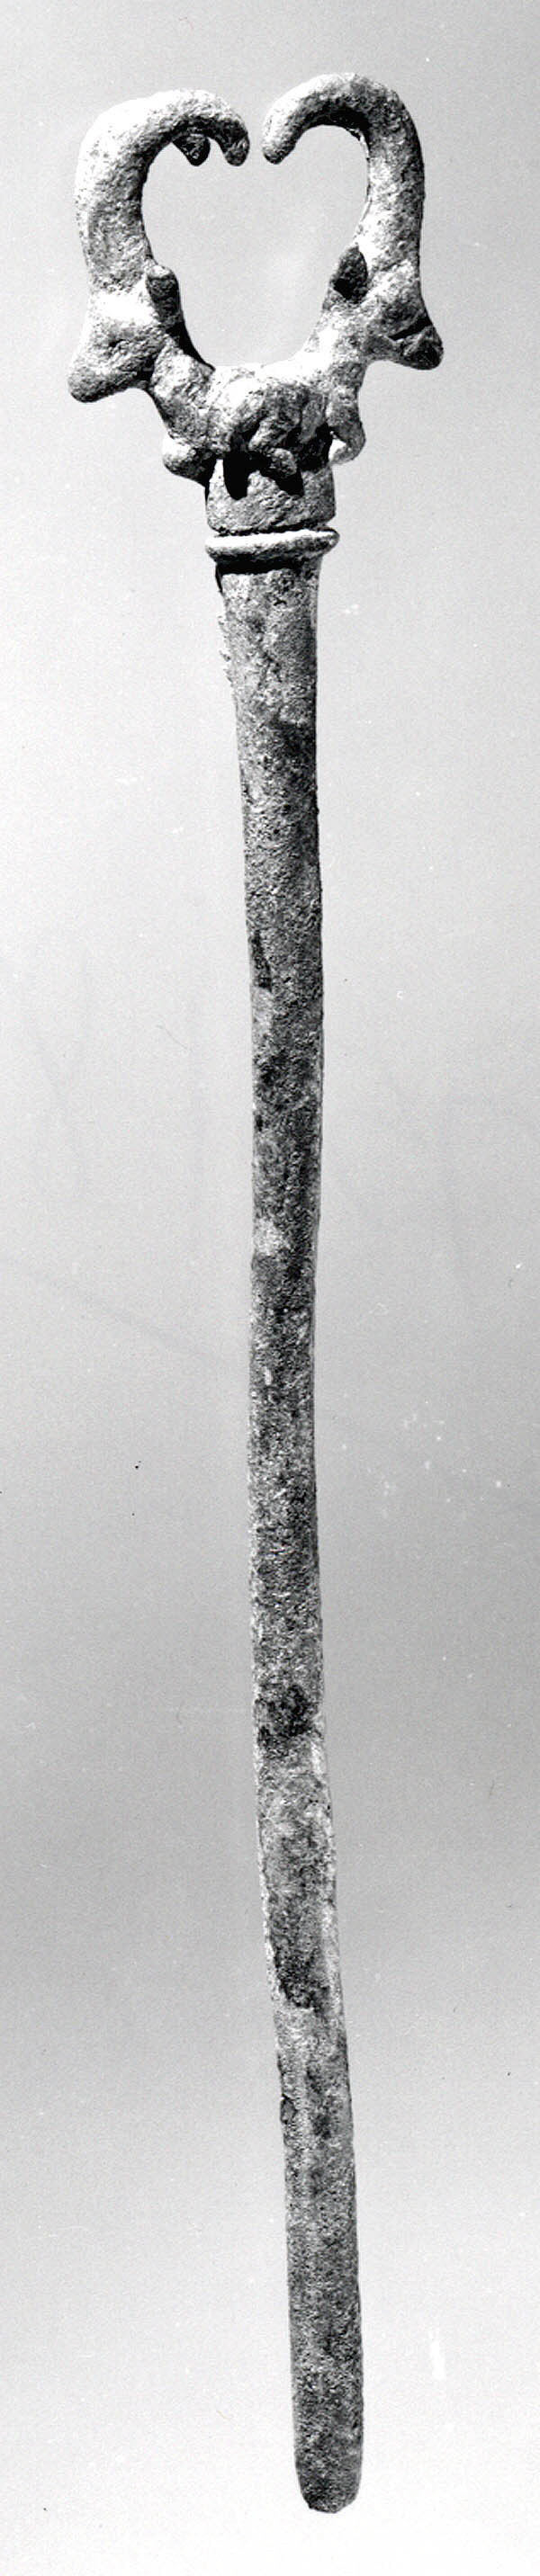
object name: pin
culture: bactria-margiana archaeological complex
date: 2333-1668 BCE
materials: copper alloy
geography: bactria-margiana